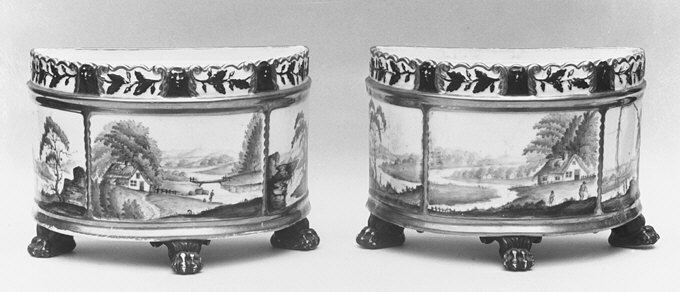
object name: cachepot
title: Pair of cachepots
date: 1701-1800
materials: hard paste porcelain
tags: landscapes